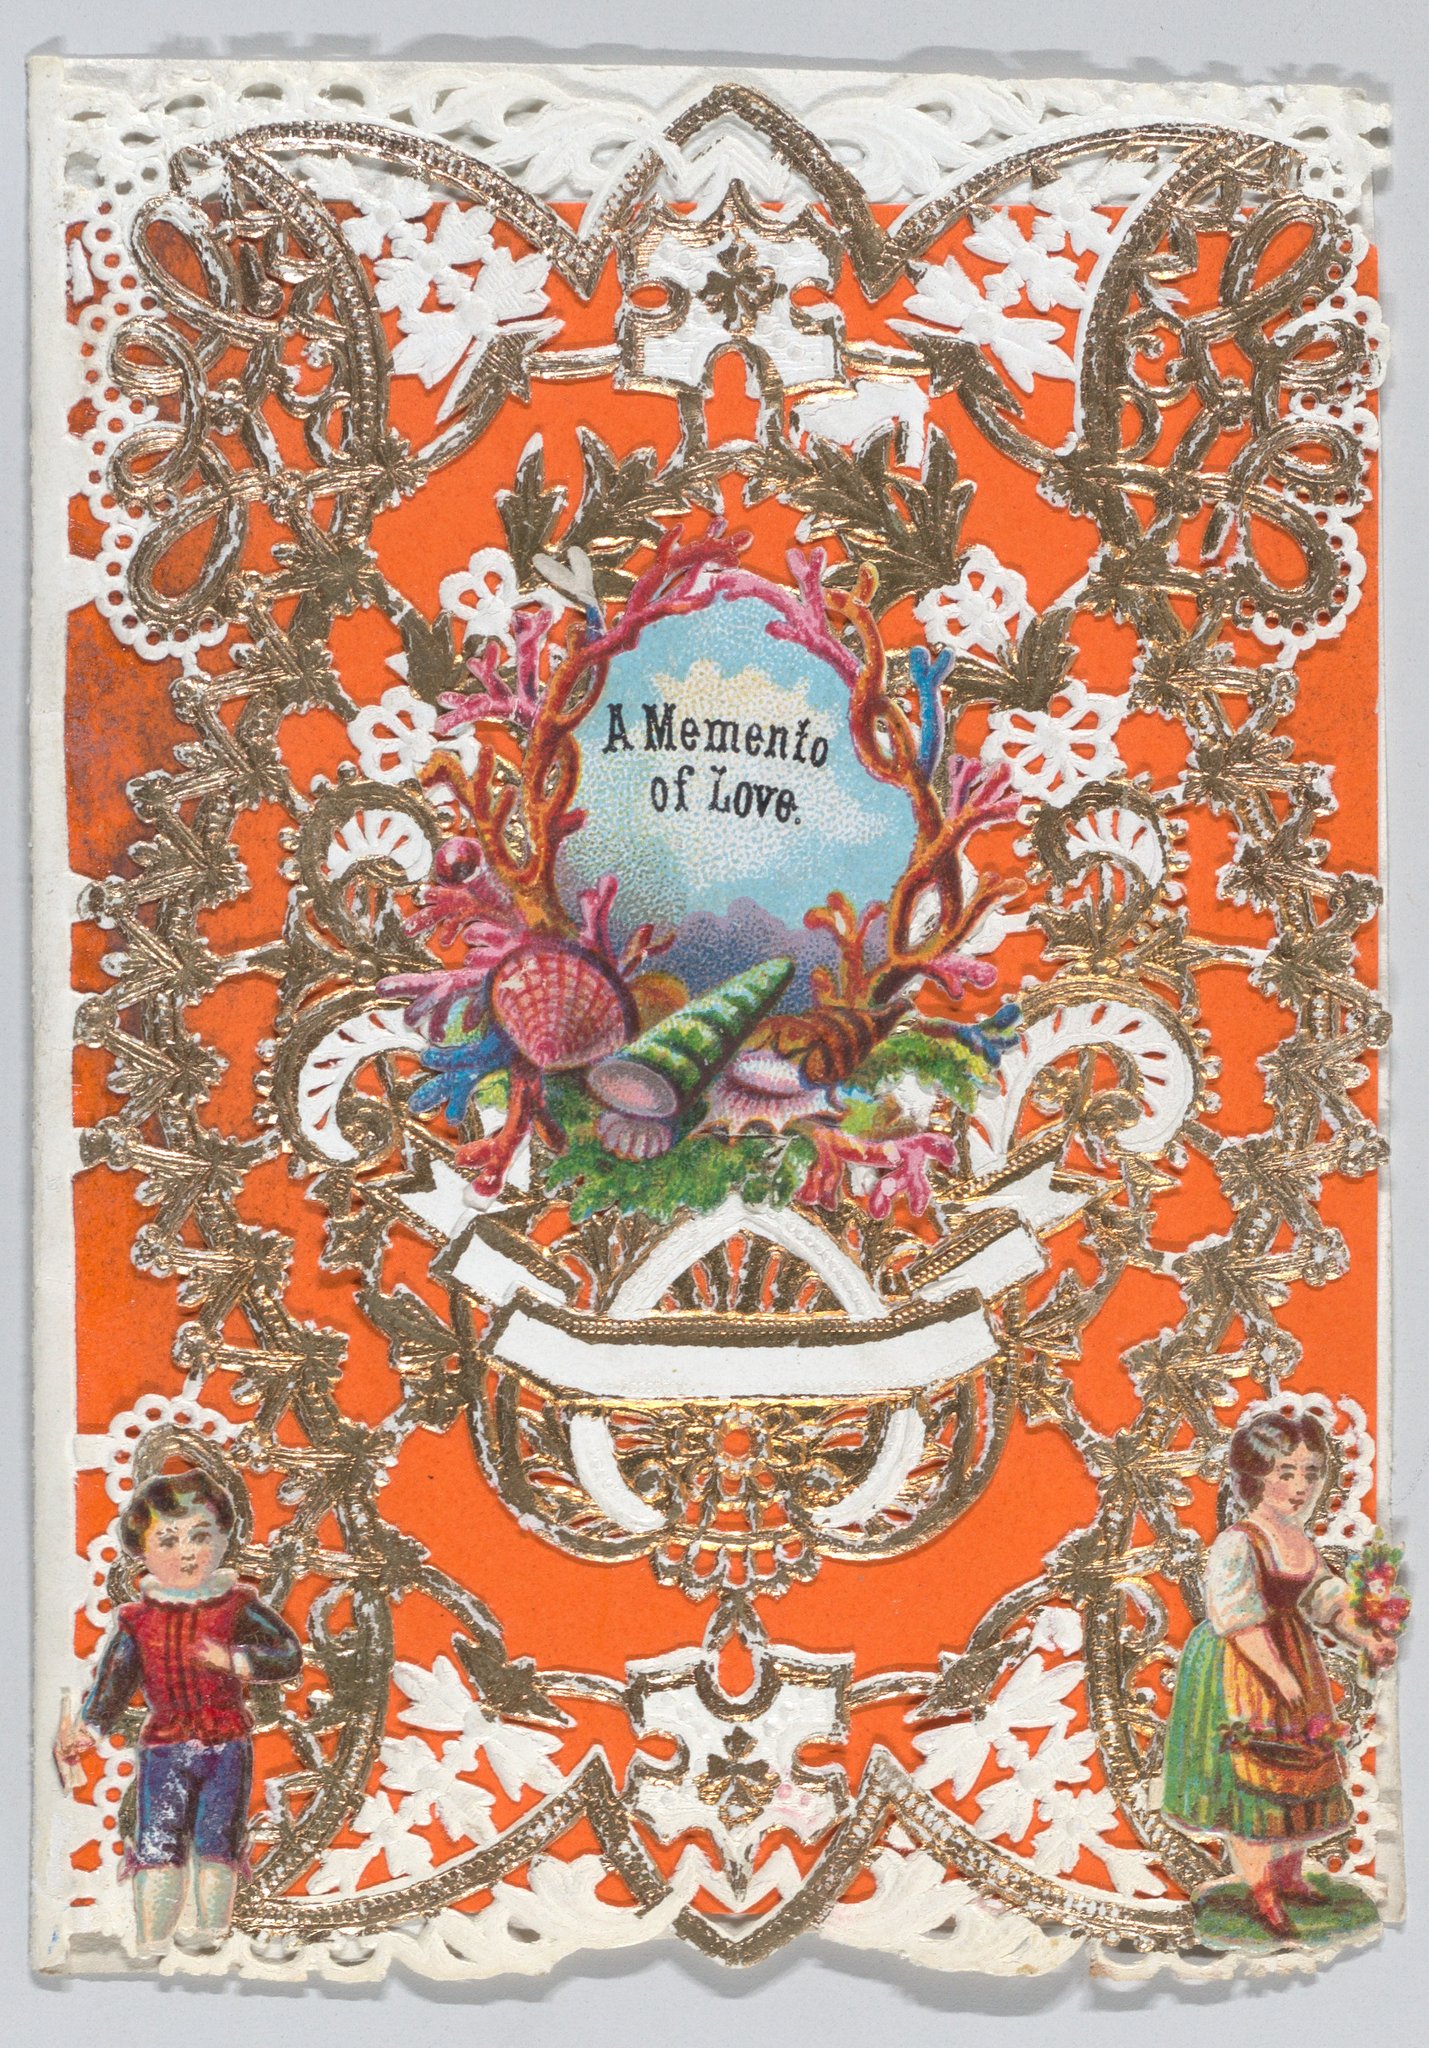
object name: valentine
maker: Anonymous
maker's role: artist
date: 1850-1870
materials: lace, paper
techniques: chromolithography, embossing, gilding